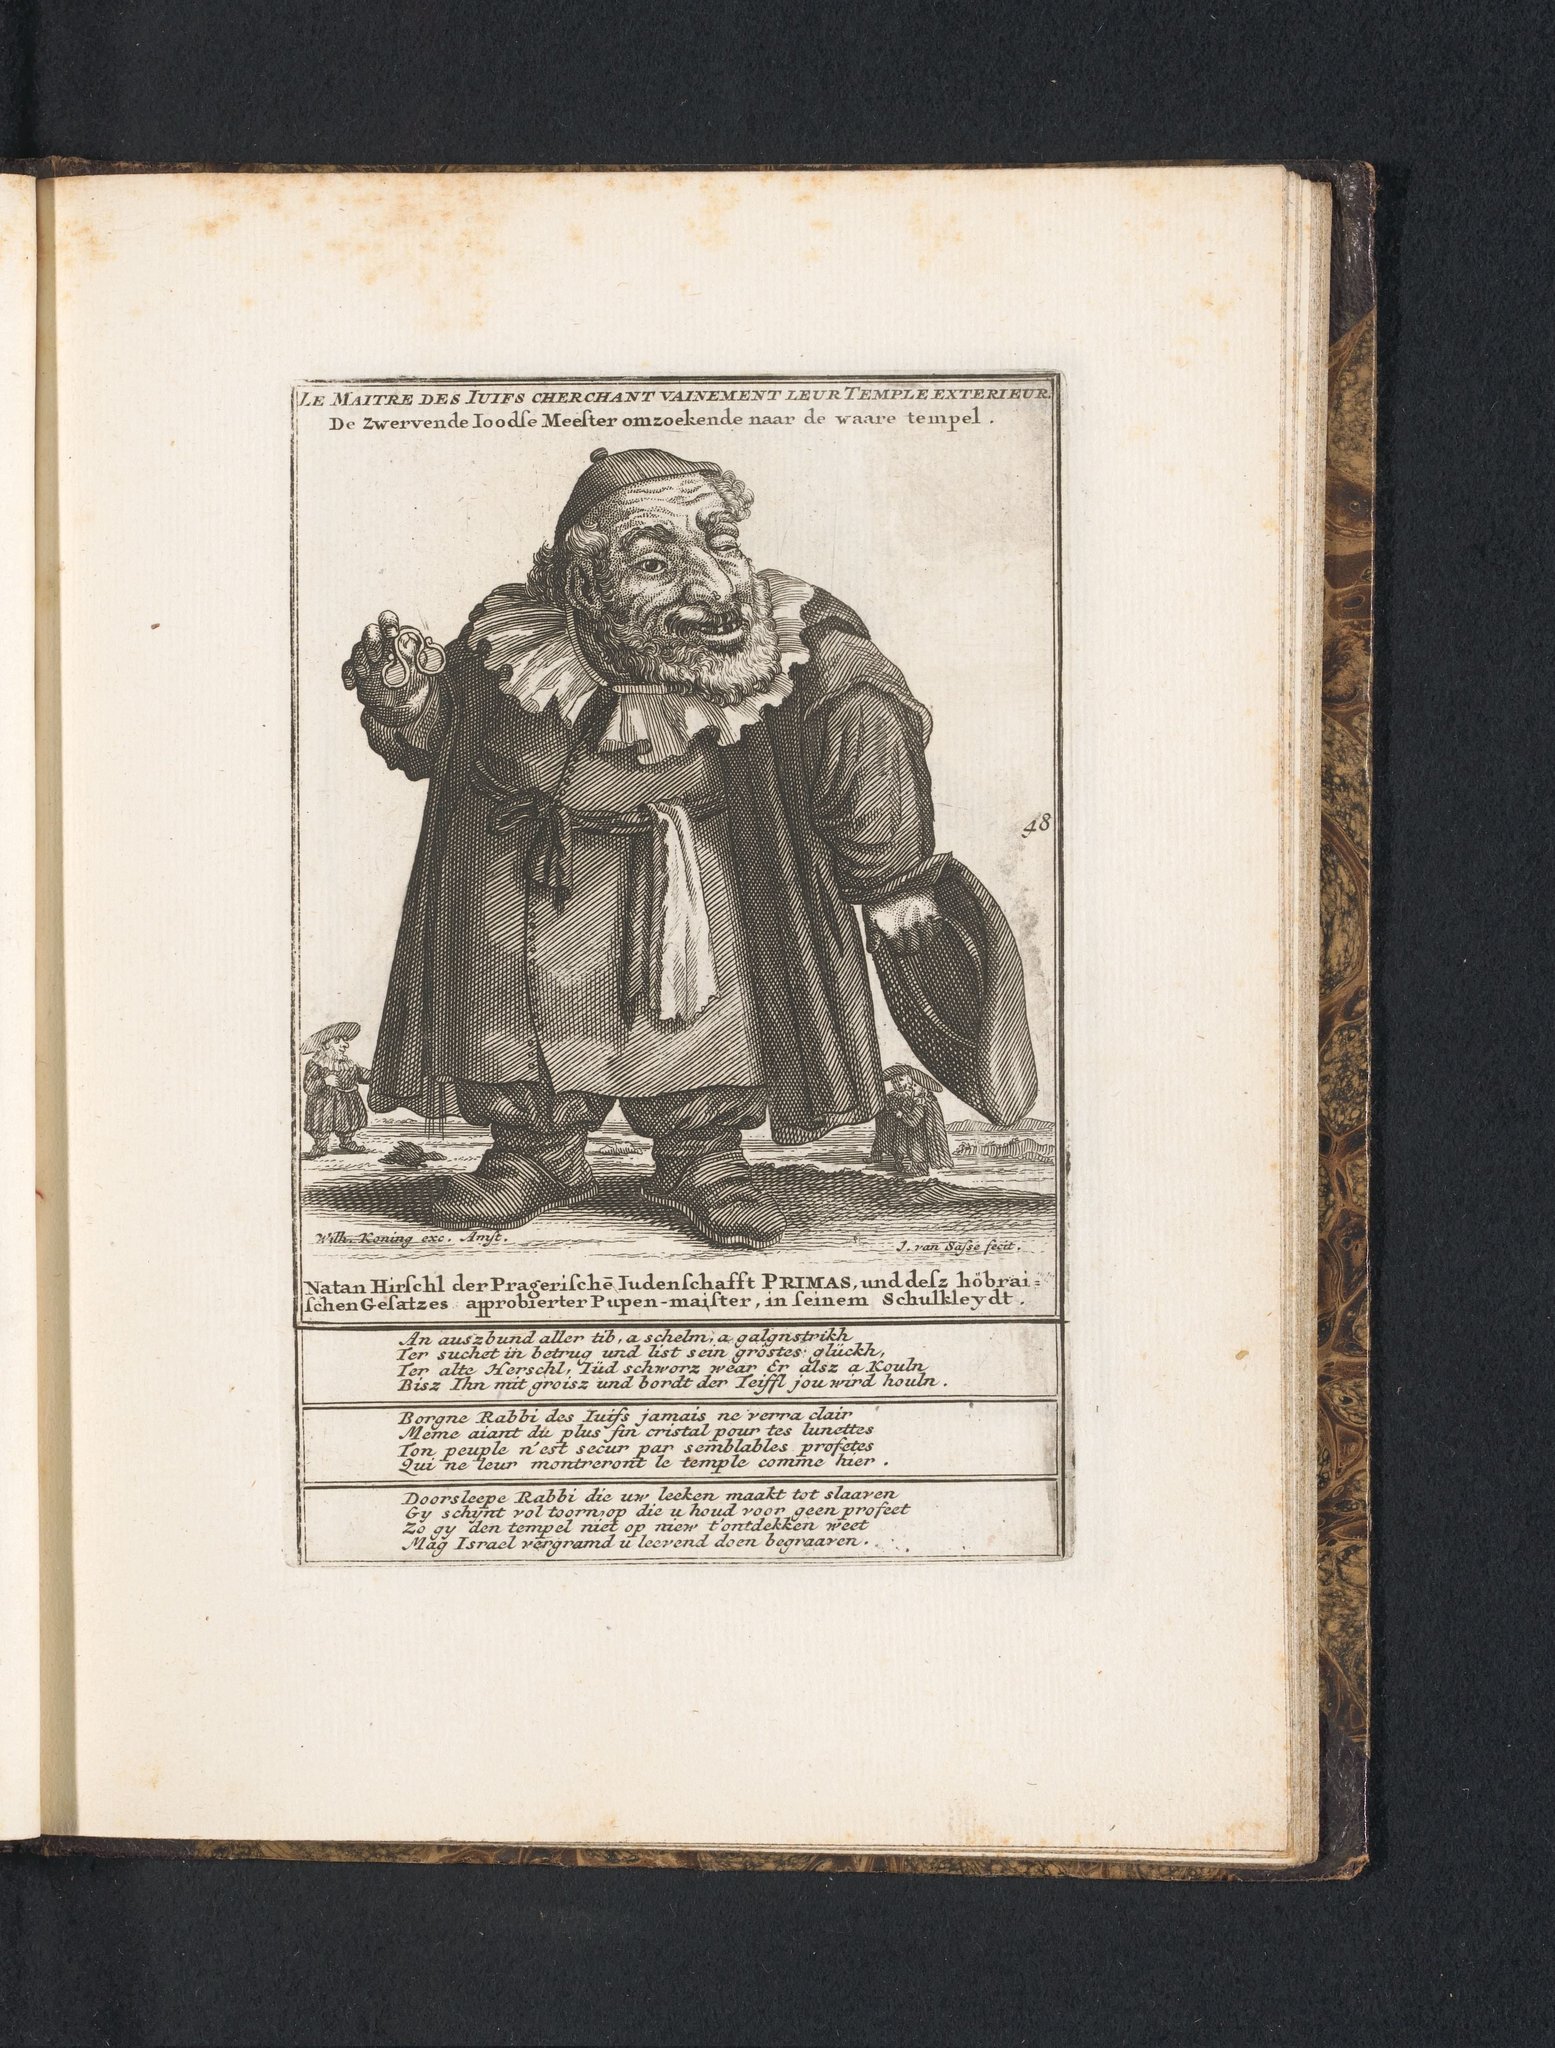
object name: print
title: De kleine mens Zwervende Joodse Meester, 1720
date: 1718-1720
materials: paper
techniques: etching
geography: northern netherlands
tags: caricatures (human types), little people, the jews, jewish life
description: De kleine mensen Zwervende Joodse Meester. In het onderschrift verzen in het Duits, Frans en Nederlands. Genummerd rechts midden: 48. Onderdeel van deel II in de tweede Nederlandse gebonden uitgave uit 1720 (en gerelateerd aan de Windhandel in dat jaar) van een serie karikaturen van kleine mensen, bekend als Het Dwergentooneel.